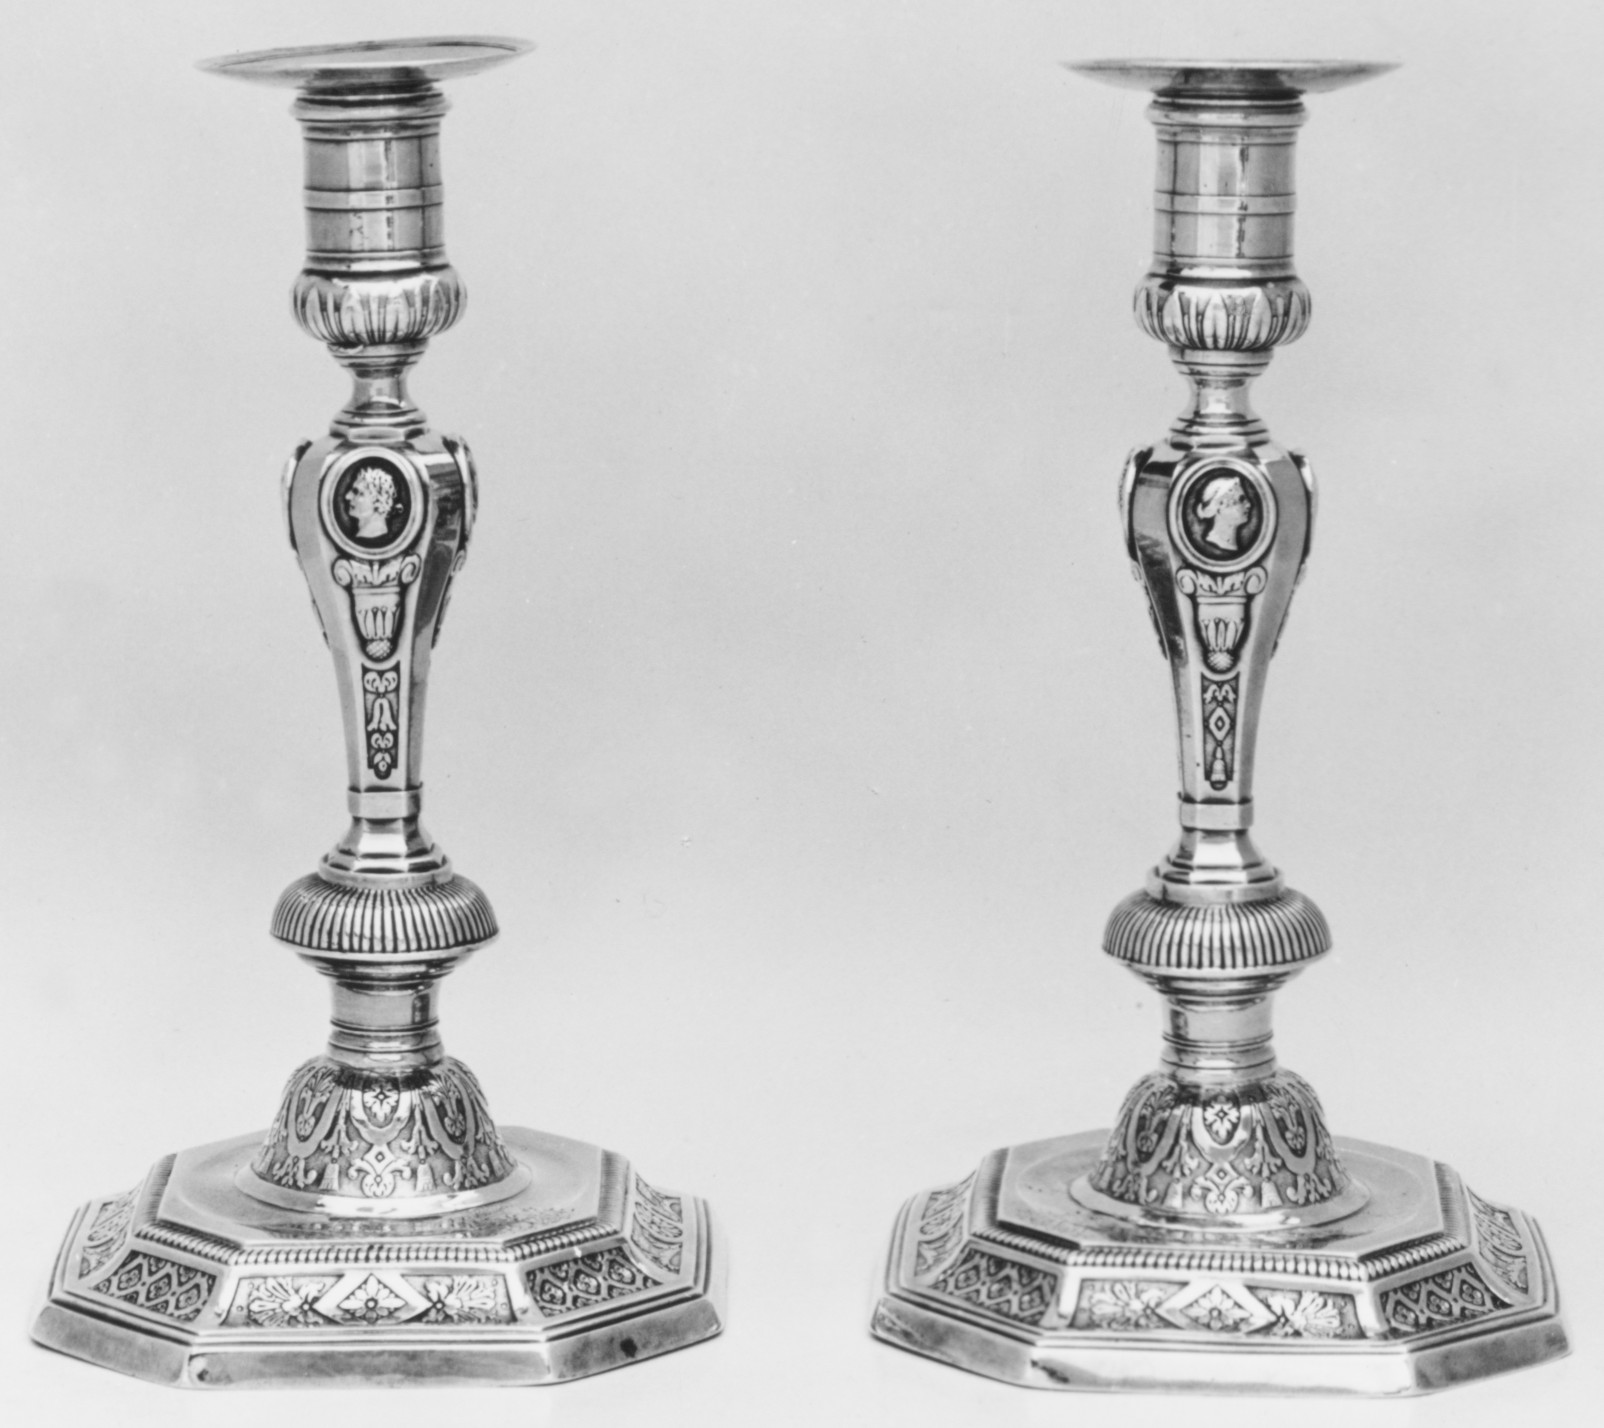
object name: candlestick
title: Pair of candlesticks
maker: jacques besnier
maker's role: maker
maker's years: 1688-1761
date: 1729-1730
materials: silver